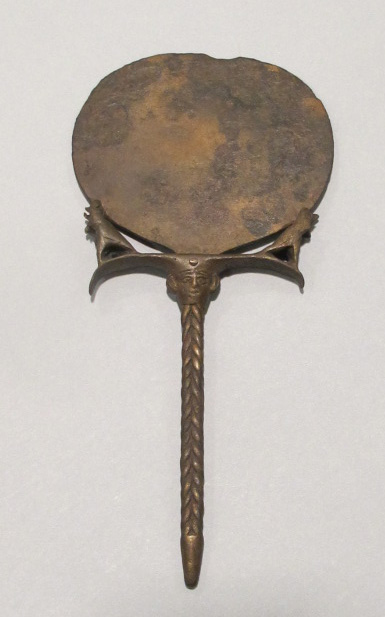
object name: mirror, papyrus, falcon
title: Mirror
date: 1550-1295 BCE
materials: bronze, copper alloy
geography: egypt